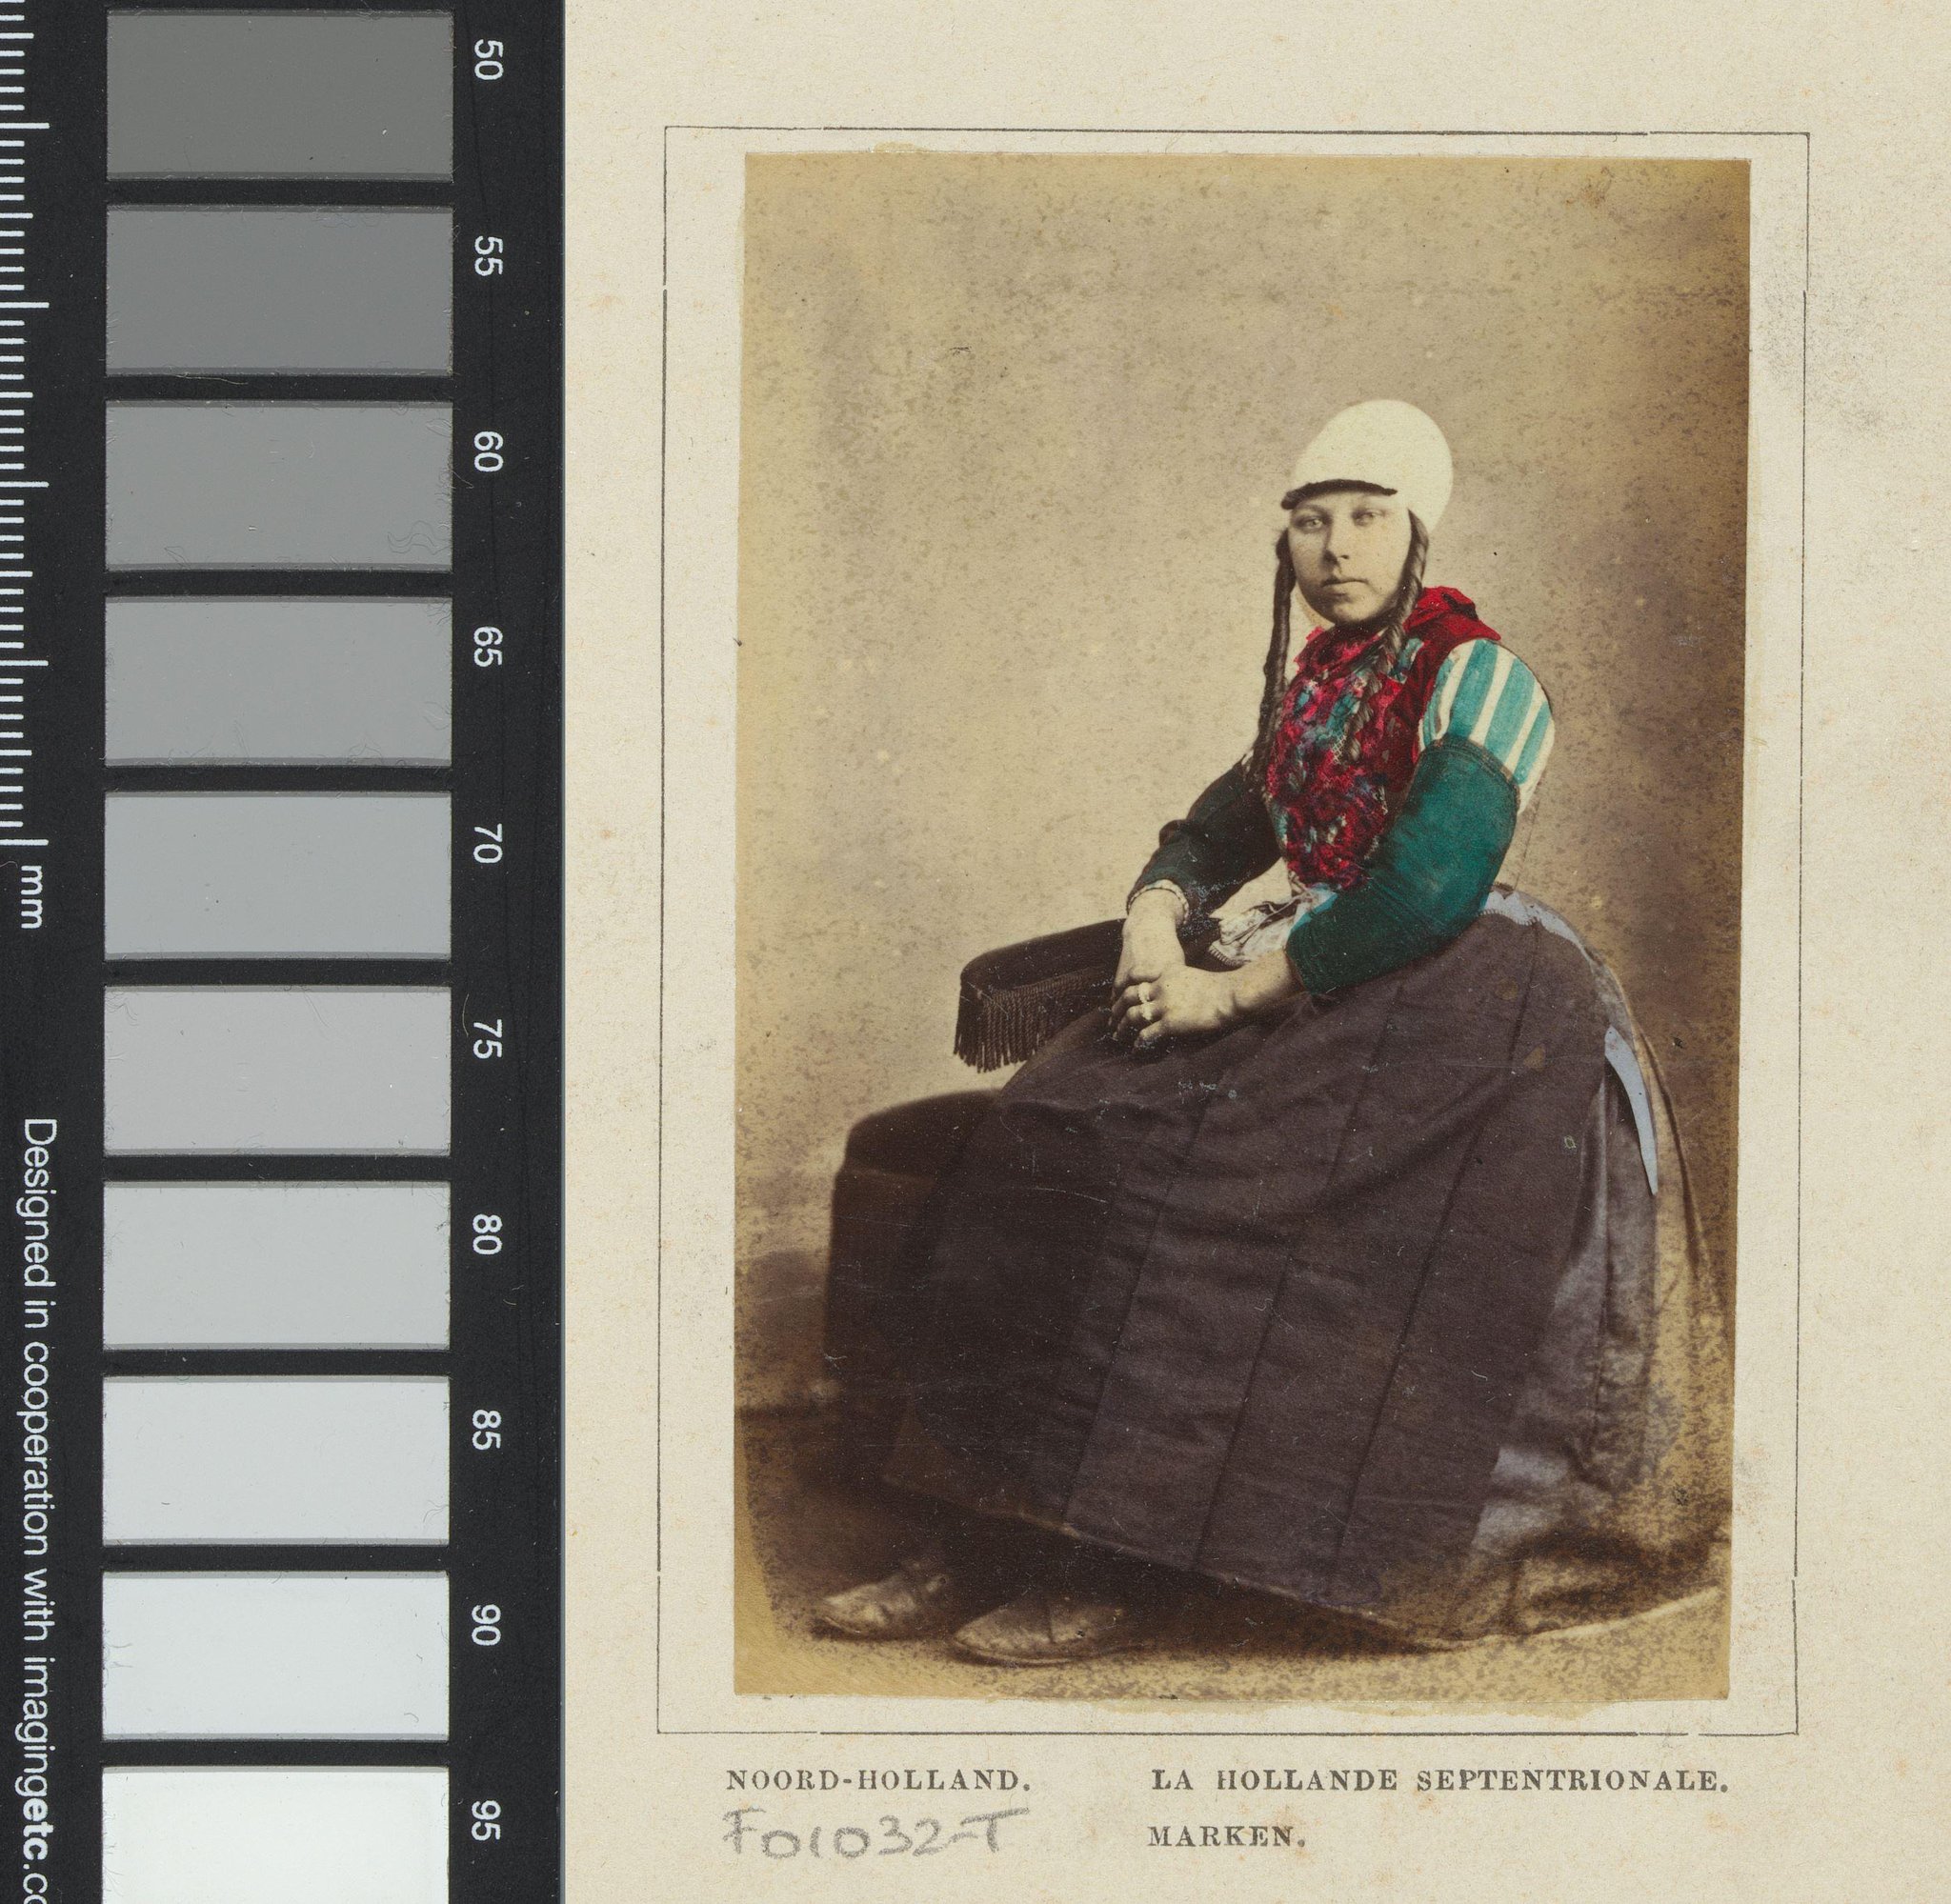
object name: photograph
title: Portret van een onbekende vrouw in klederdracht van Marken, Noord-Holland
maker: andries jager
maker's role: publisher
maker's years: 1825-1905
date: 1860-1890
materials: cardboard, photographic support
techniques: albumen print, hand coloring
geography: amsterdam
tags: folk costume, regional costume (+ women's clothes), historical persons - bb - woman, europeans (with name), netherlands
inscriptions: inscription: ‘Uitgave van A. JAGER, Water 110 te Amsterdam.’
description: Deze foto maakt deel uit van een omslag met 48 foto's op 12 bladen.